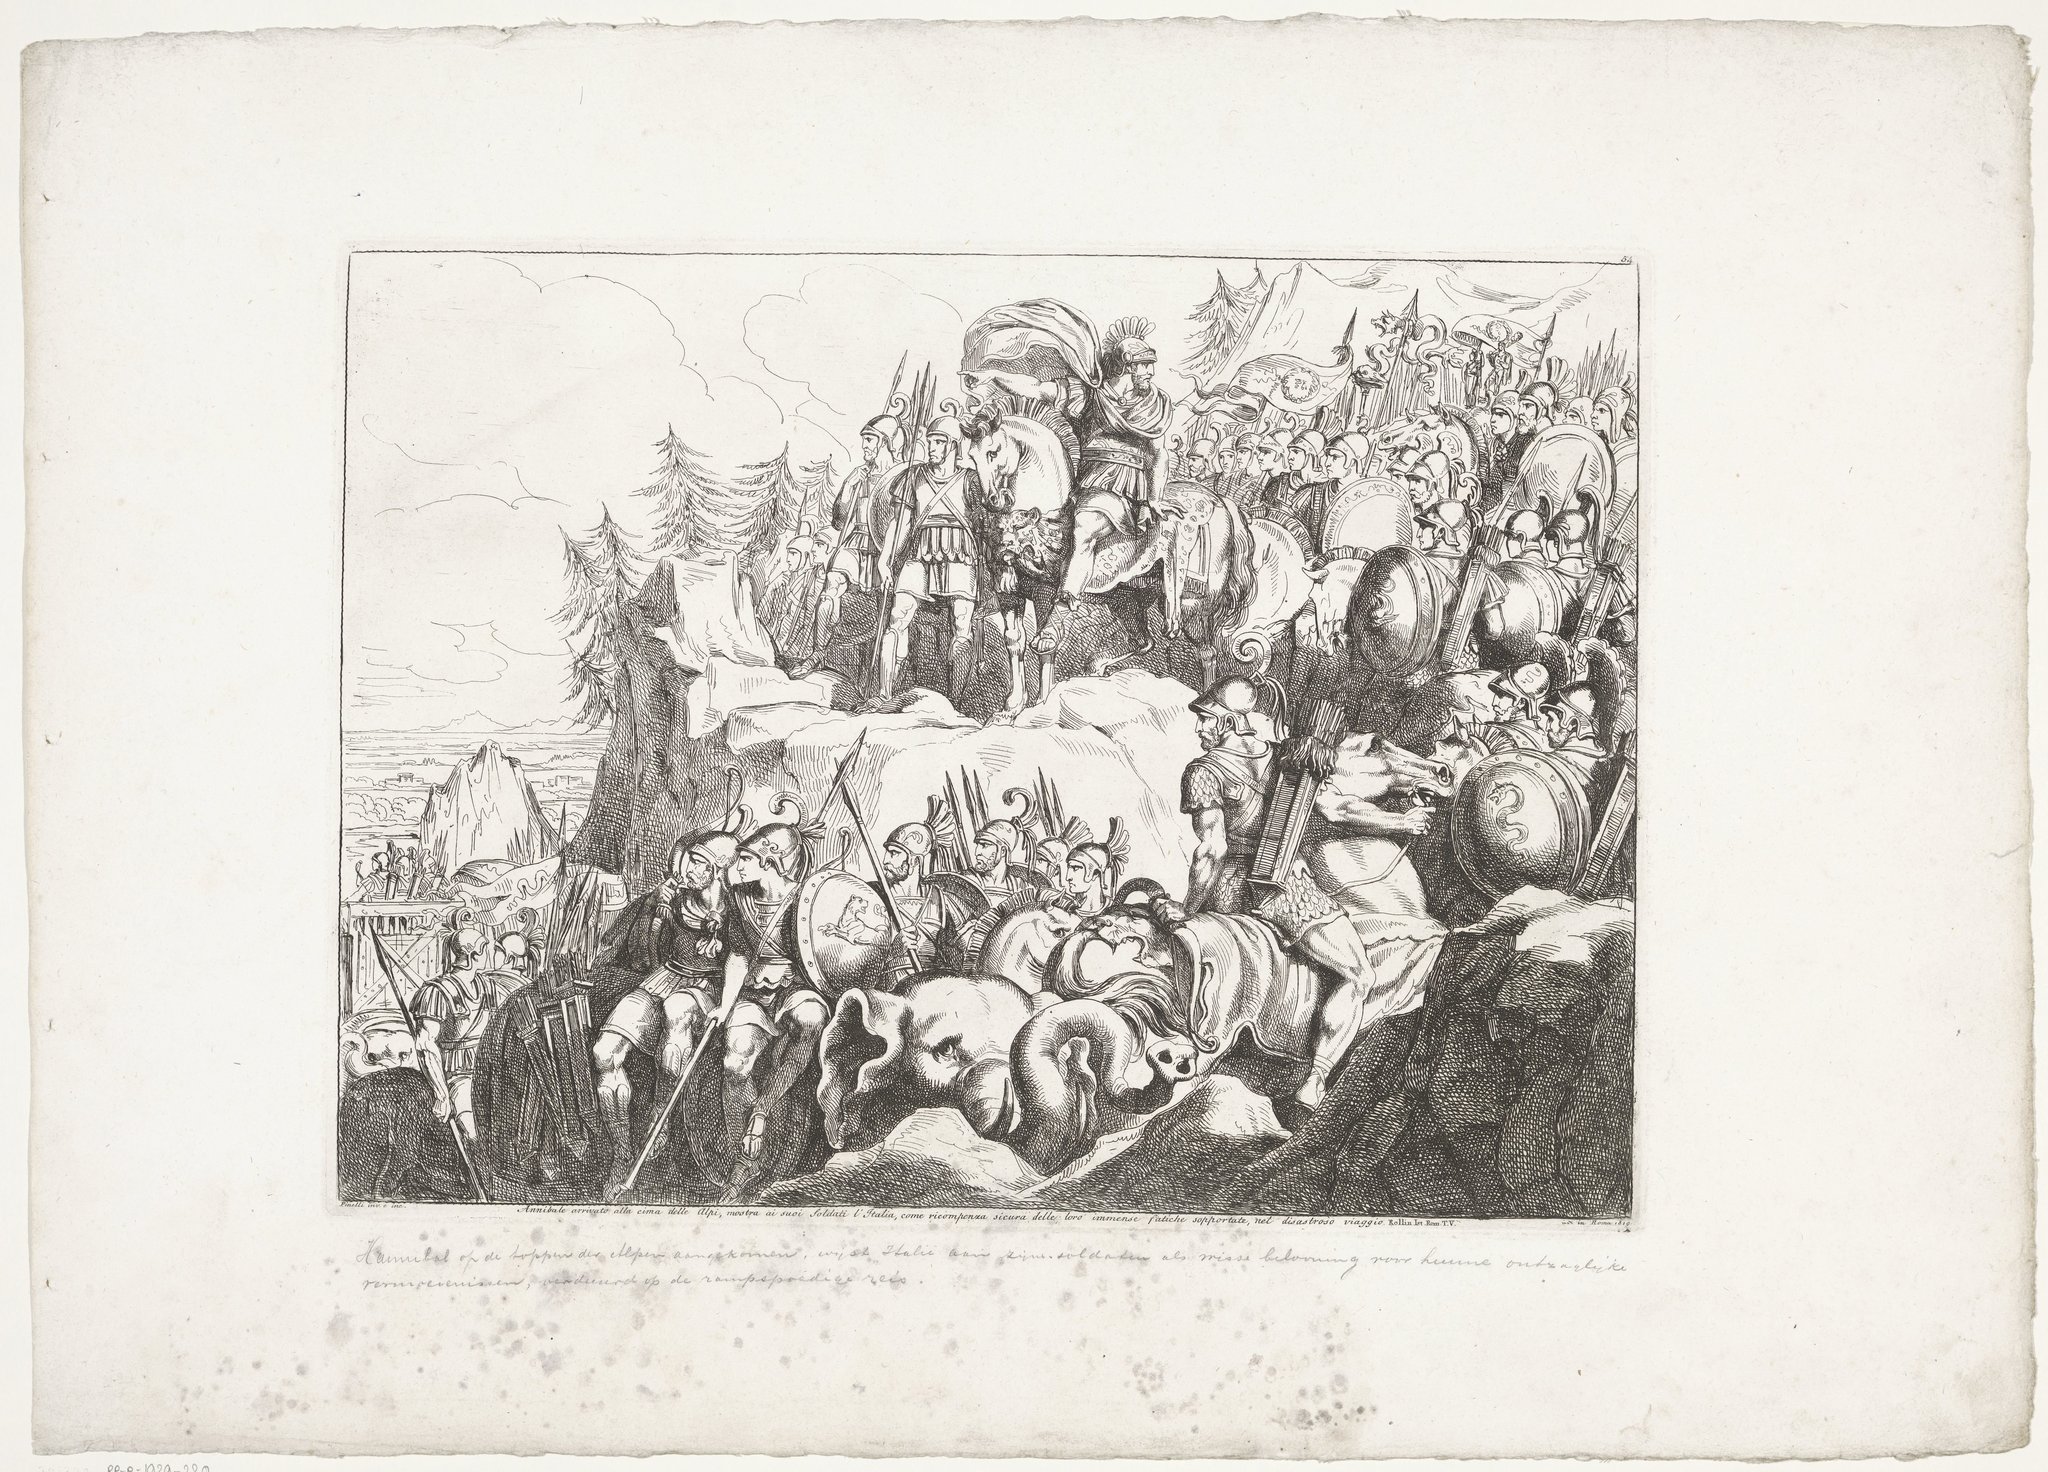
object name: print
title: Hannibal steekt de Alpen over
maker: bartolomeo pinelli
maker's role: draughtsman, print maker, sculptor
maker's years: 1781-1835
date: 1819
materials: paper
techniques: etching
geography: rome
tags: hannibal crosses the alps with his army and his elephants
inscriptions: inscription: ‘Hannibal op de toppen der Alpen aangekomen, wijst Italië aan zijne soldaten als wisse beloning voor hunne ontzaglijke...’, collector's mark: Lugt 2228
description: Hannibal en zijn leger met paarden en olifanten staat op de top van de Alpen. Hij wijst naar Italië.